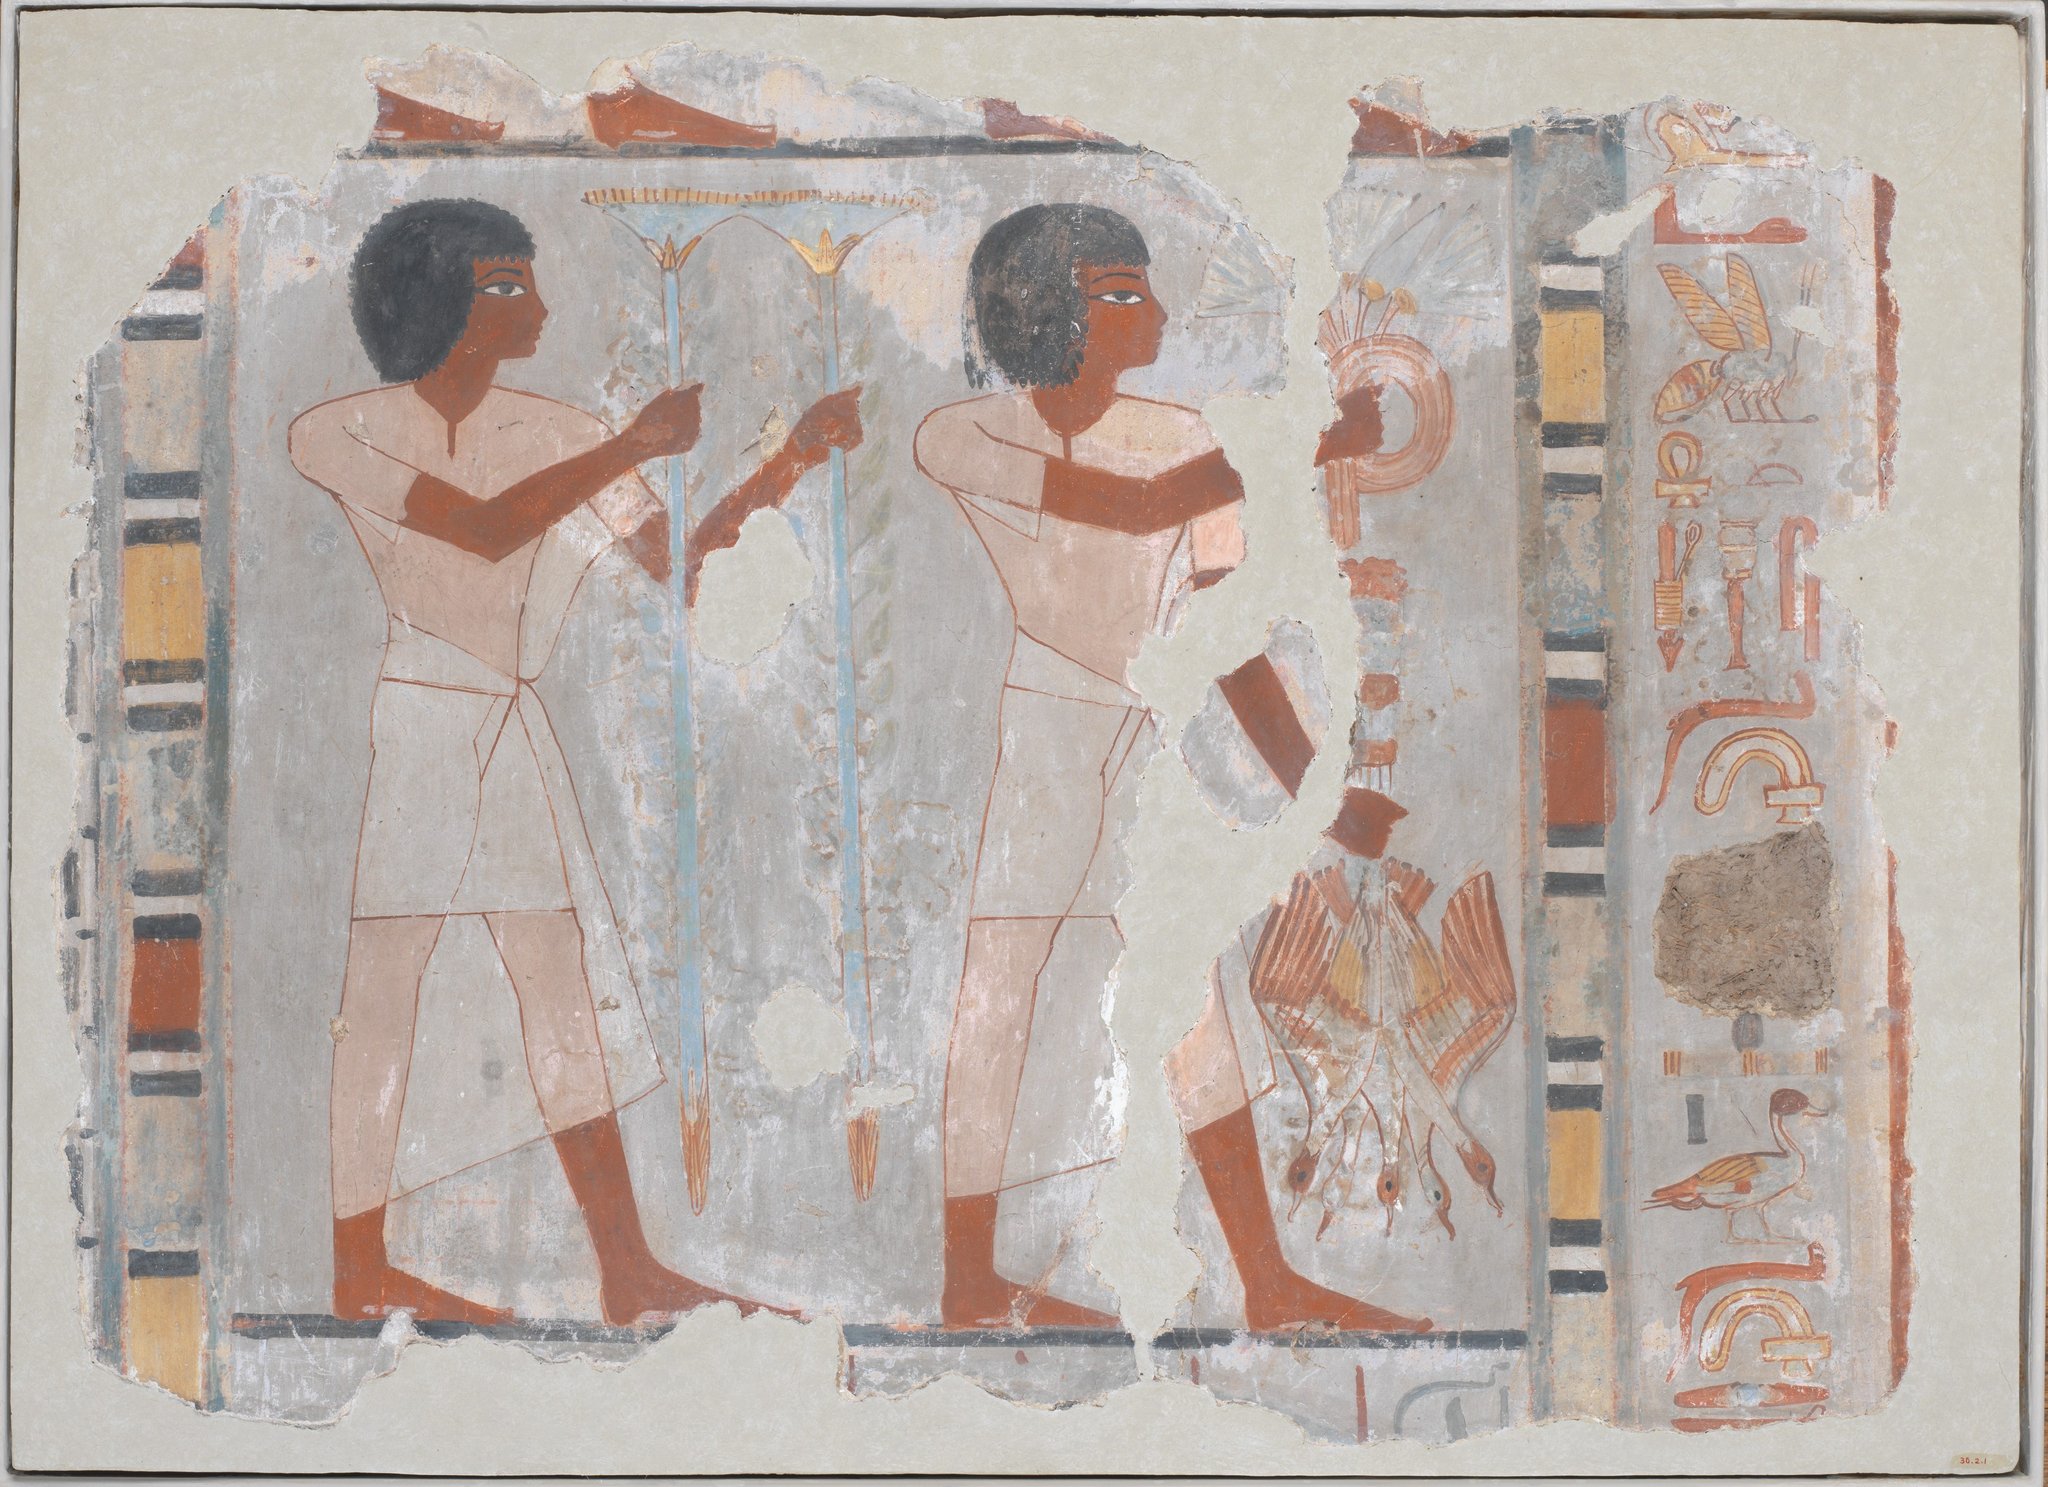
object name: wall painting, tomb of sebekhotep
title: Fragment of wall painting from the Tomb of Sebekhotep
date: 1550-1295 BCE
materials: mud, paint, plaster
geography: egypt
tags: tombs,men,hieroglyphs